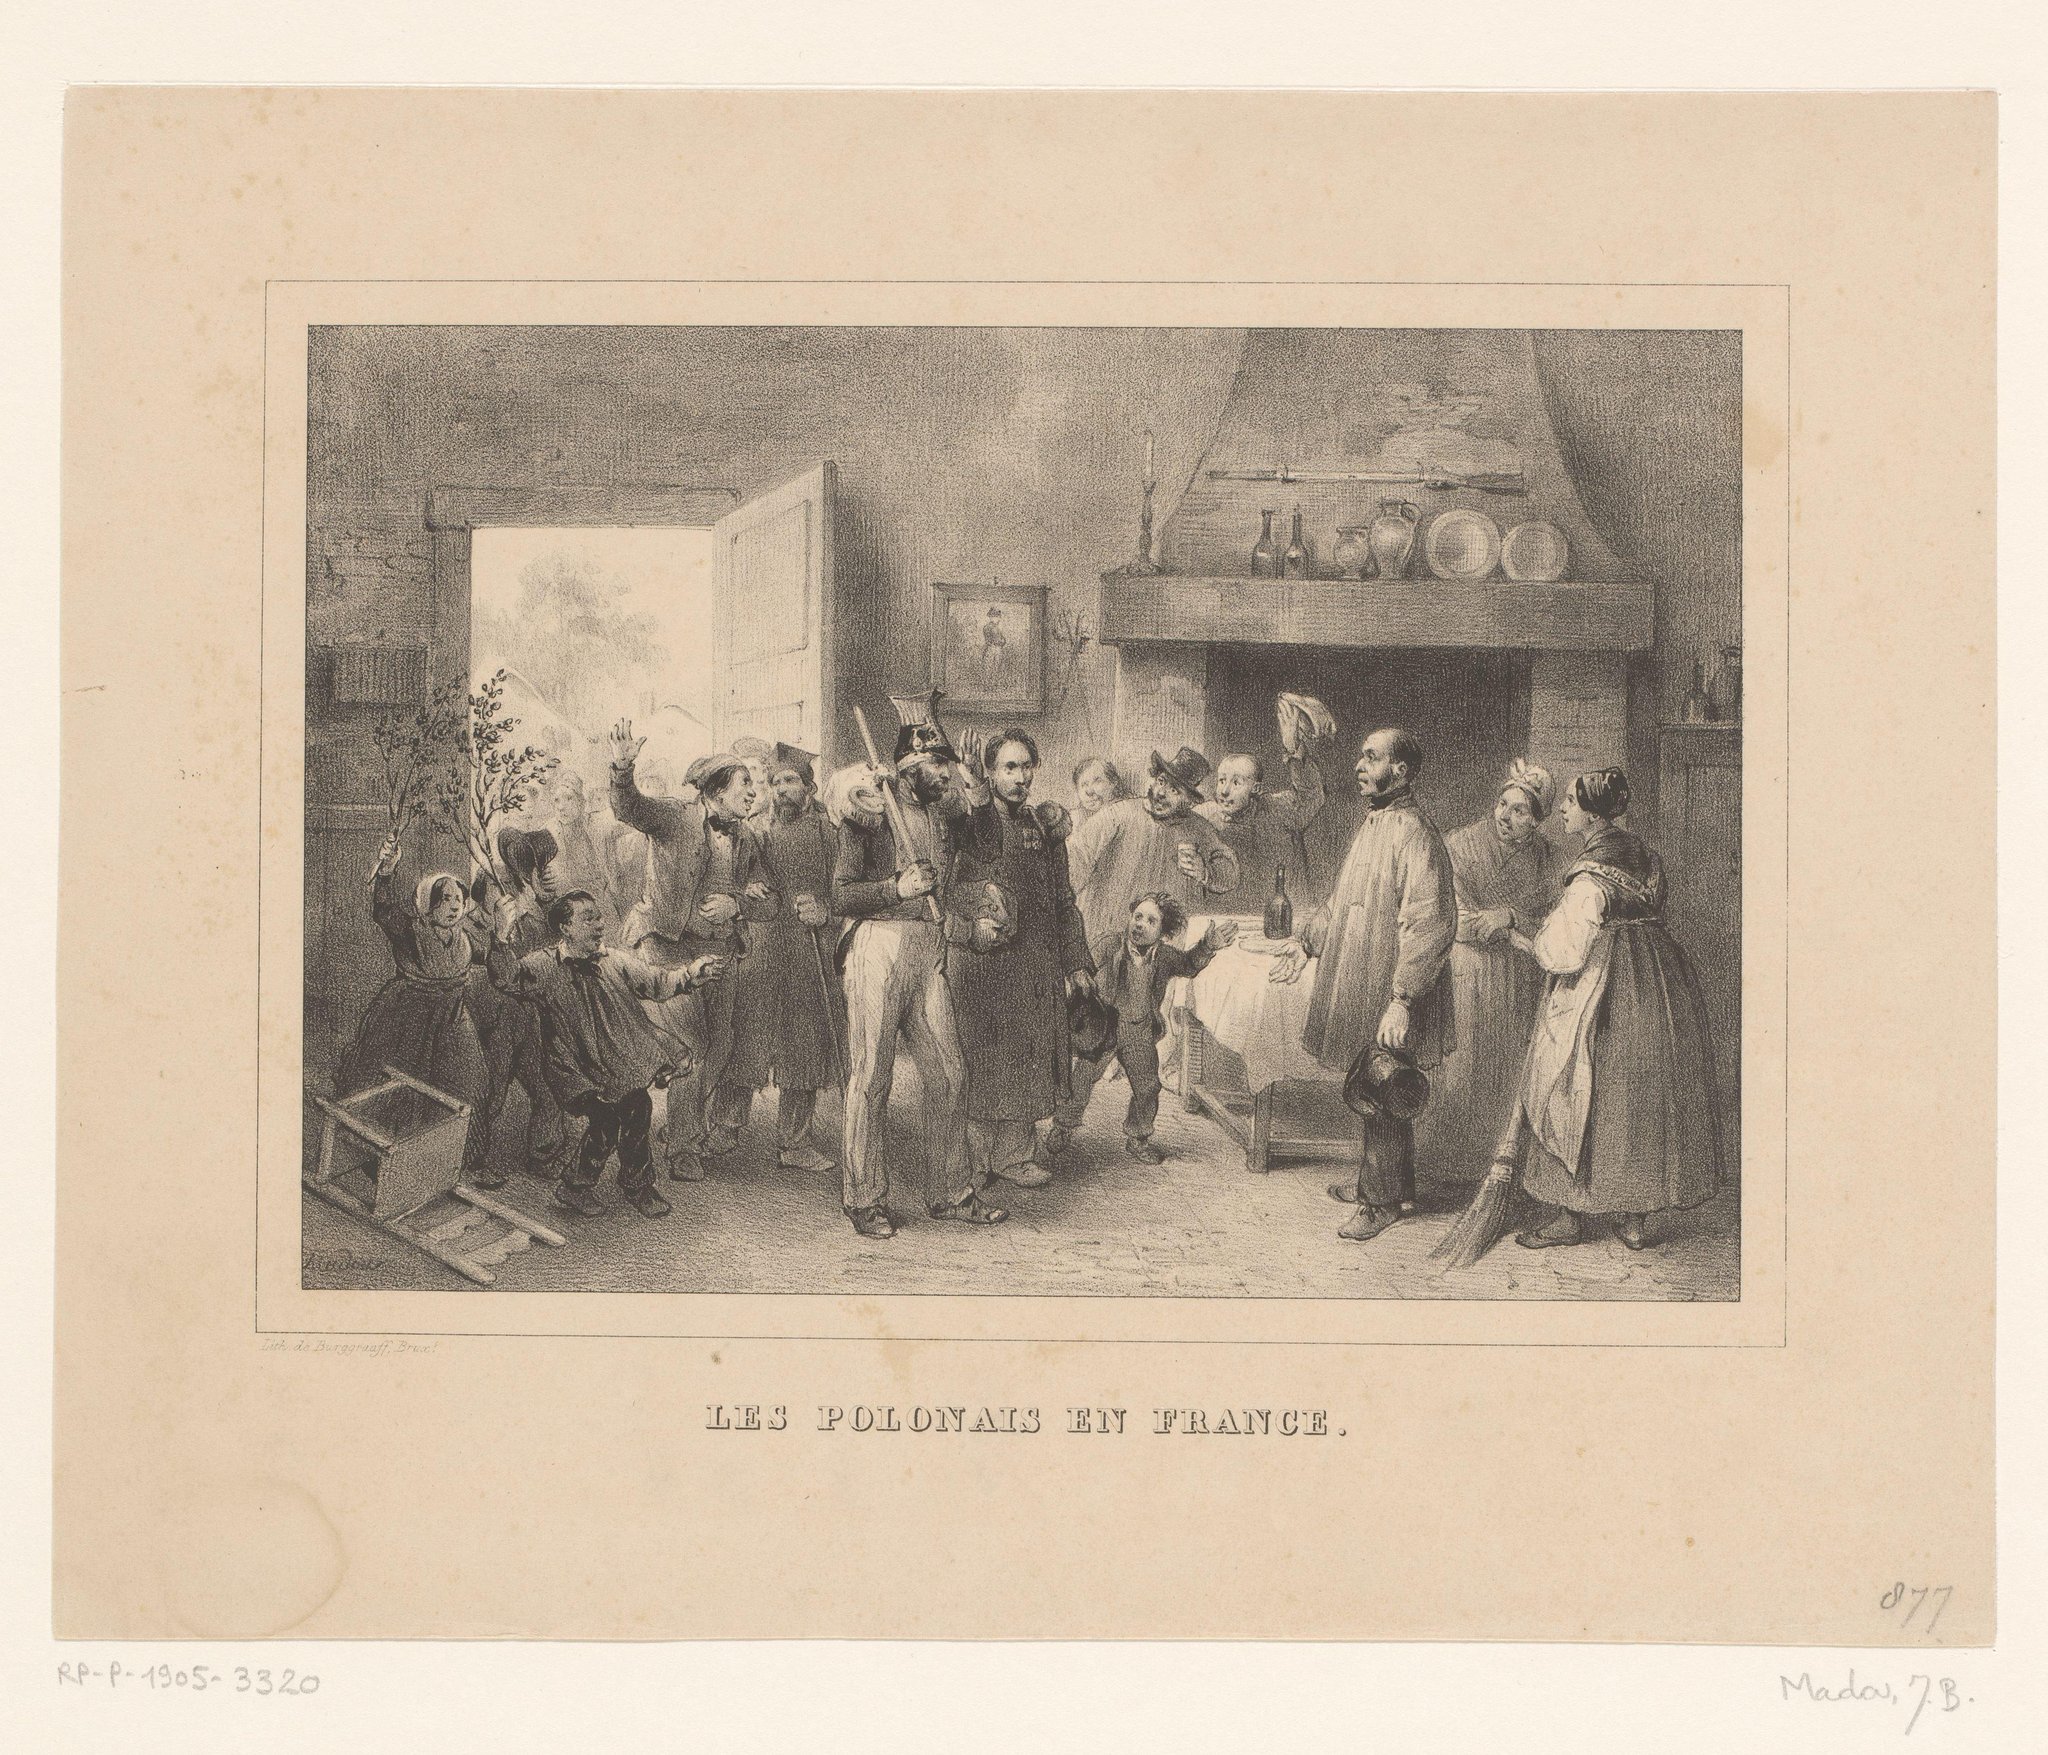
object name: print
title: Militairen worden ontvangen in een herberg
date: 1834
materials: paper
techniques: lithograph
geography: brussels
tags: visiting; receiving guests; elegant company, inn, coffee-house, public house, etc., officer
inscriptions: collector's mark: Lugt 2228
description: Madou lithografeerde voor Modeste Rottermund, Pools officier in Belgische dienst, vijf prenten. Het album was bedoeld als herinnering aan het gastvrije onthaal dat de Poolse officieren ontvingen in Europa na de Poolse opstand.